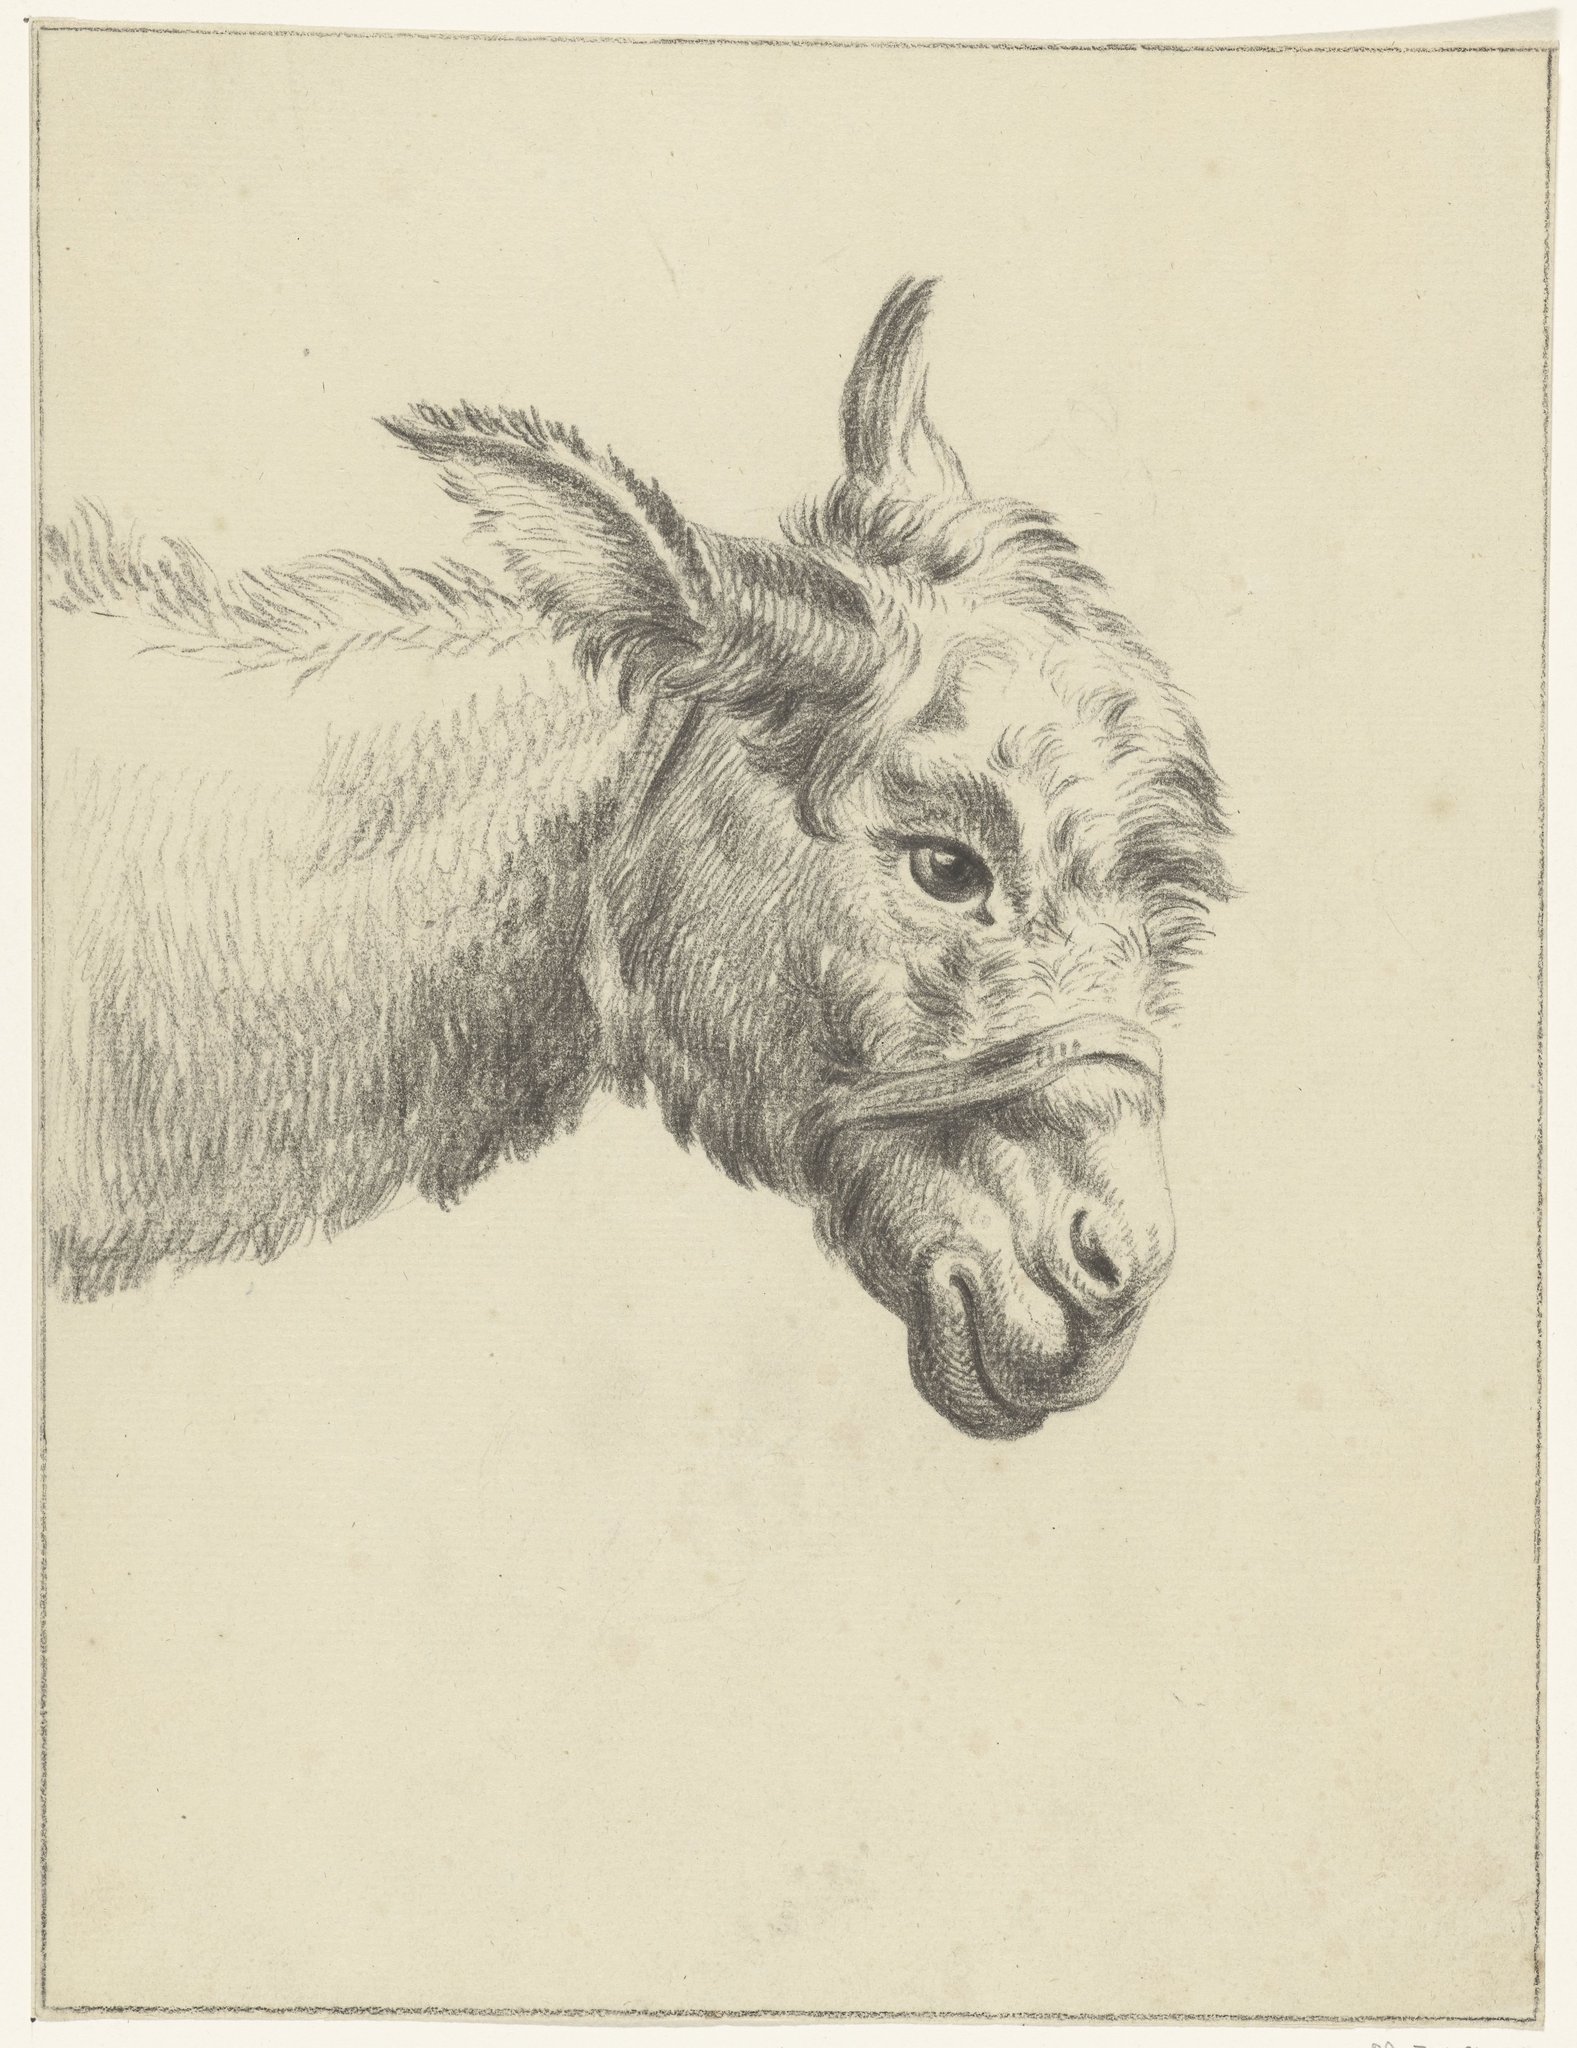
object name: drawing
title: Kop van een ezel, naar rechts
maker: jean bernard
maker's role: draughtsman, print maker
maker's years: 1765-1833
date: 1775-1833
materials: chalk, paper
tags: ass, donkey